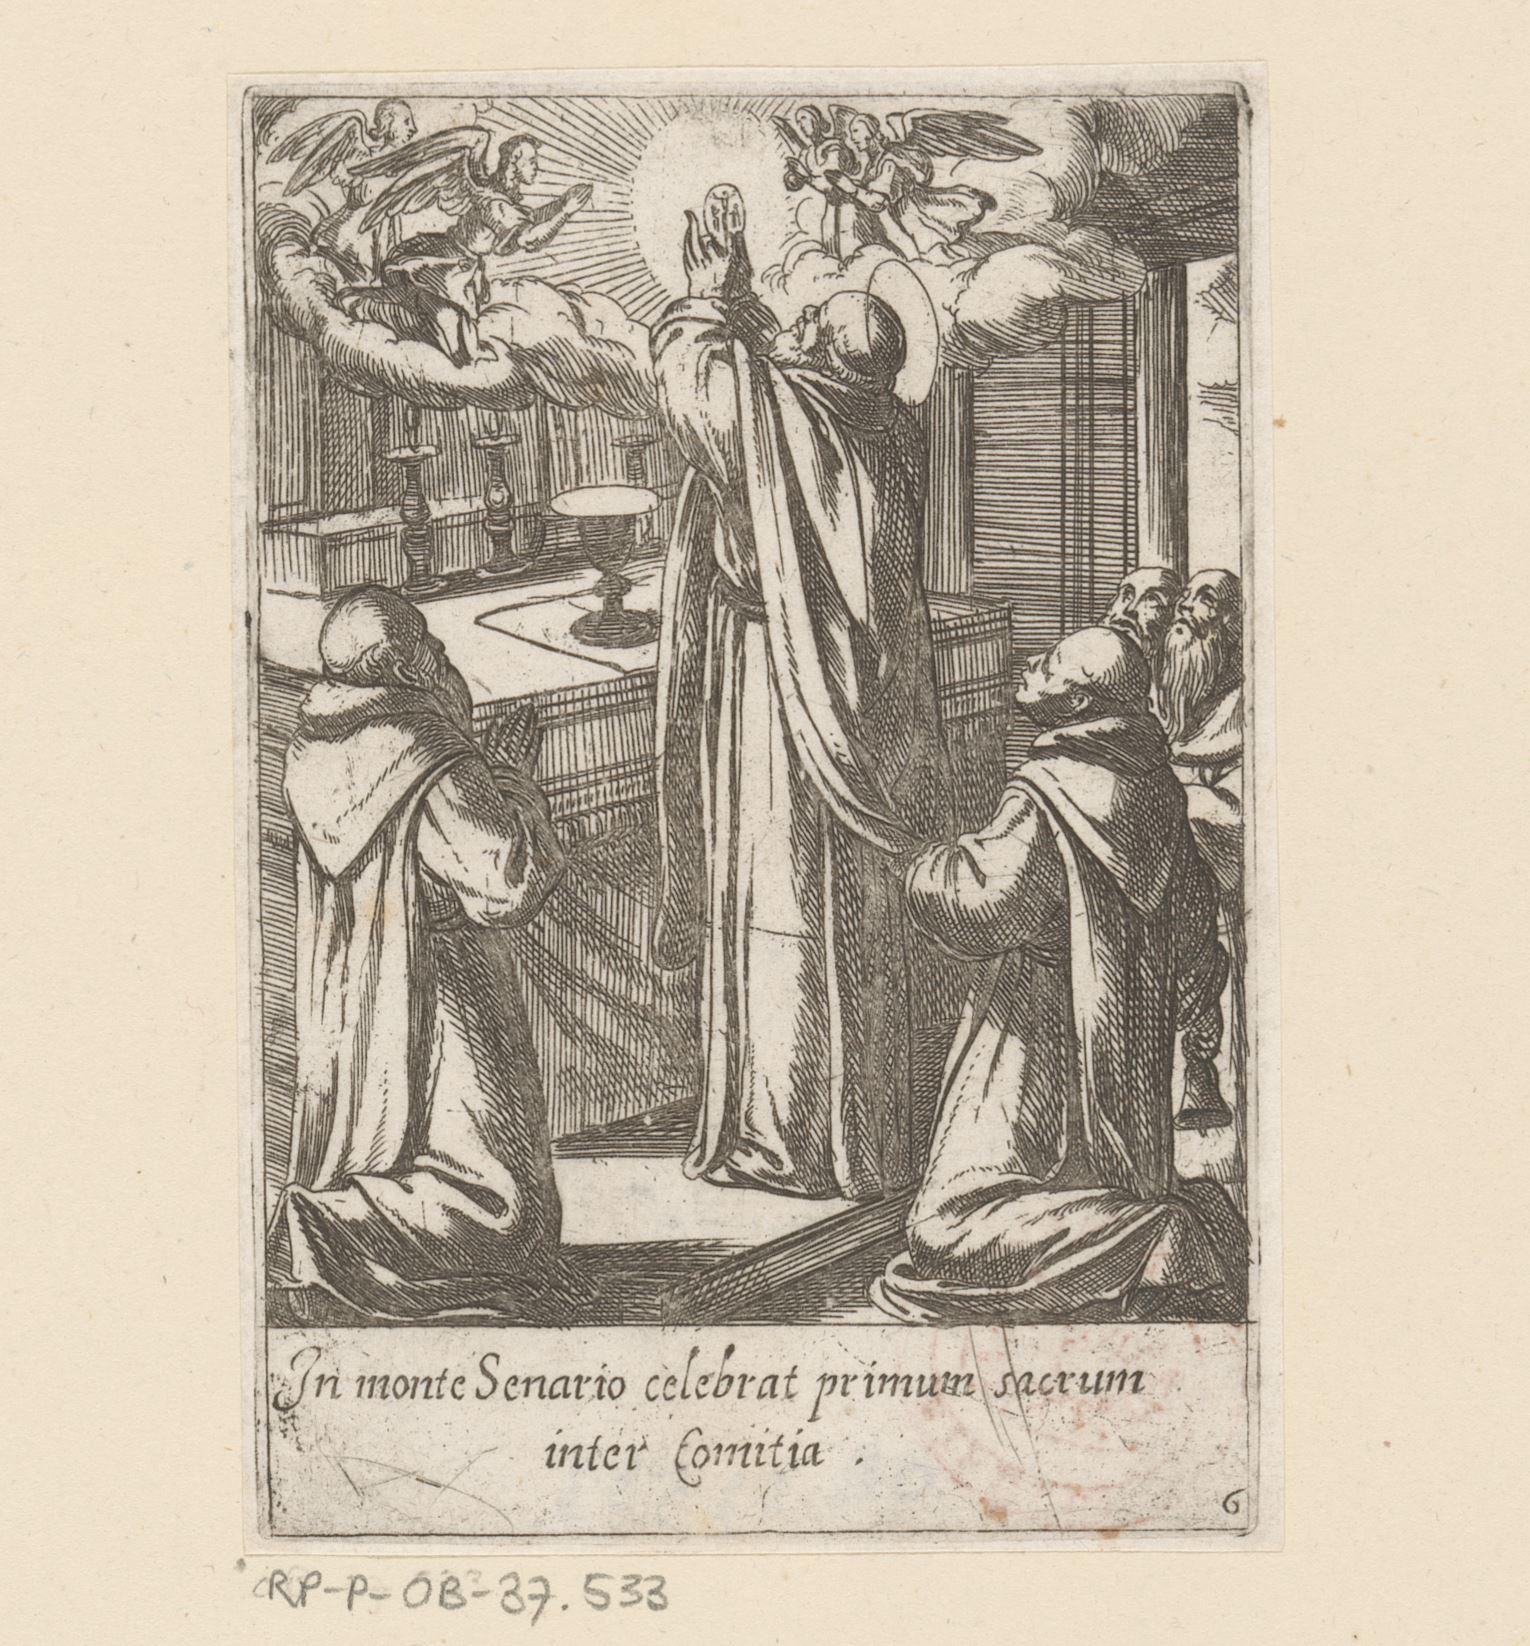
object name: print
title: De heilige Philippus viert de mis te Monte Senario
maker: antonio tempesta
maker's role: draughtsman, painter, print maker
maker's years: 1555-1630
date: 1591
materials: paper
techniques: etching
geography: vatican city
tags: clergyman, prior general of the order of the servites, philip benizzi of florence; possible attributes: book, cross, lily, tiara at his feet, angels, sermon ~ holy mass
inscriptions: collector's mark: Lugt 240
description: De heilige Philippus viert de mis te Monte Senario. Hij staat voor een altaar met een hostie en engelen. Tekst in het Latijn in ondermarge. Genummerd rechtsonder: 6.